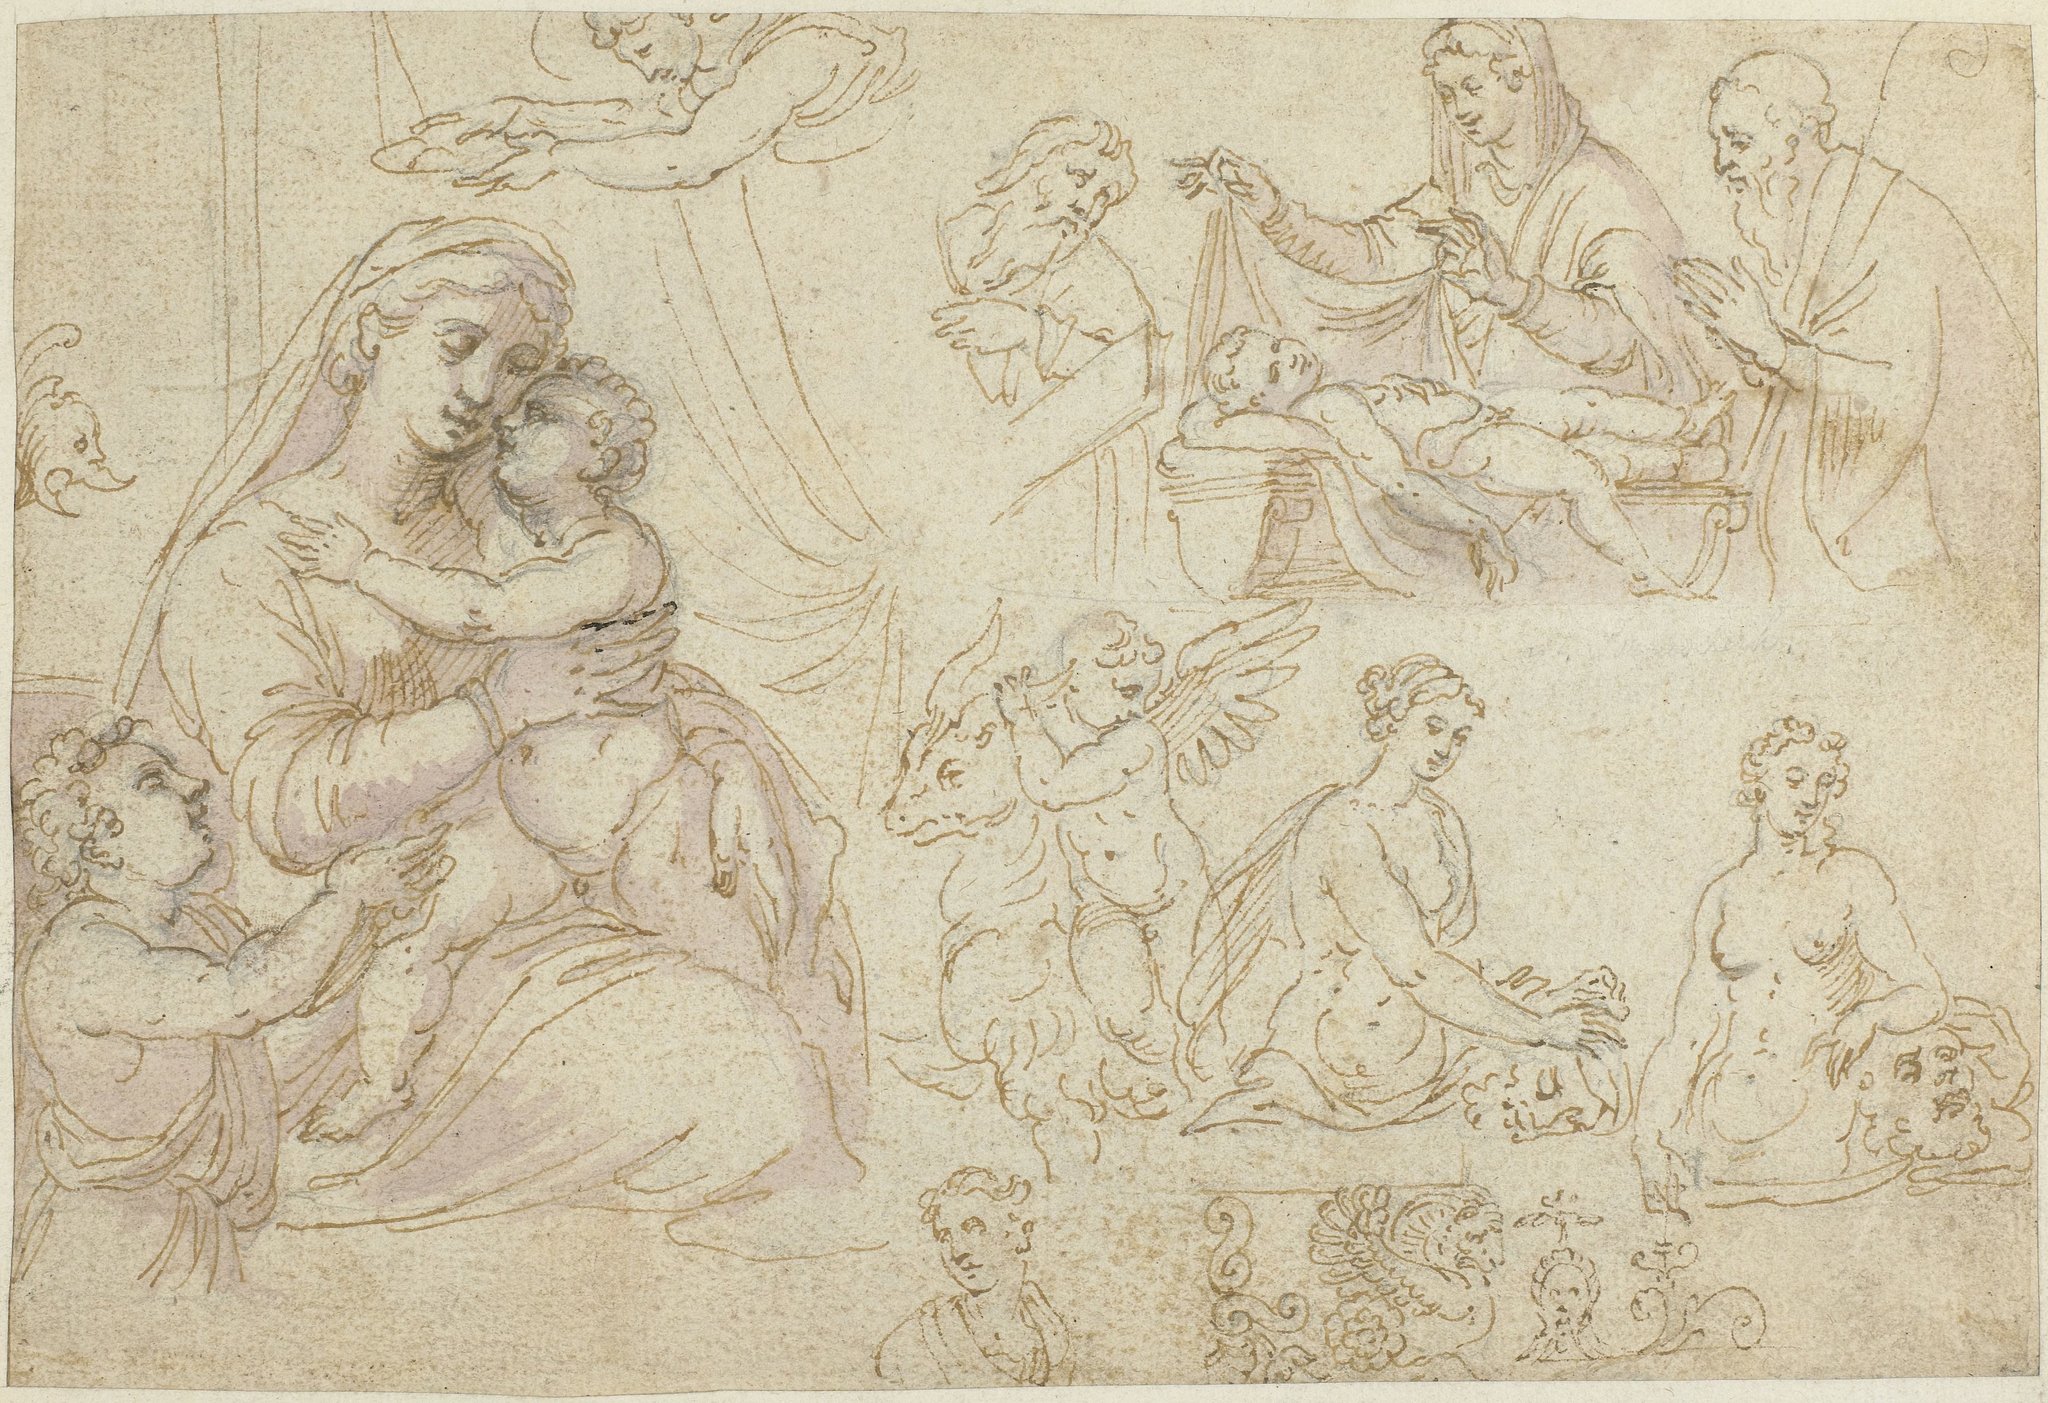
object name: kopie naar schilderij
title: Schilderijen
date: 1550-1570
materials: chalk, ink, paper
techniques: pen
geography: low countries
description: Album "Maarten de Vos schetsboek", blad 11r(12).